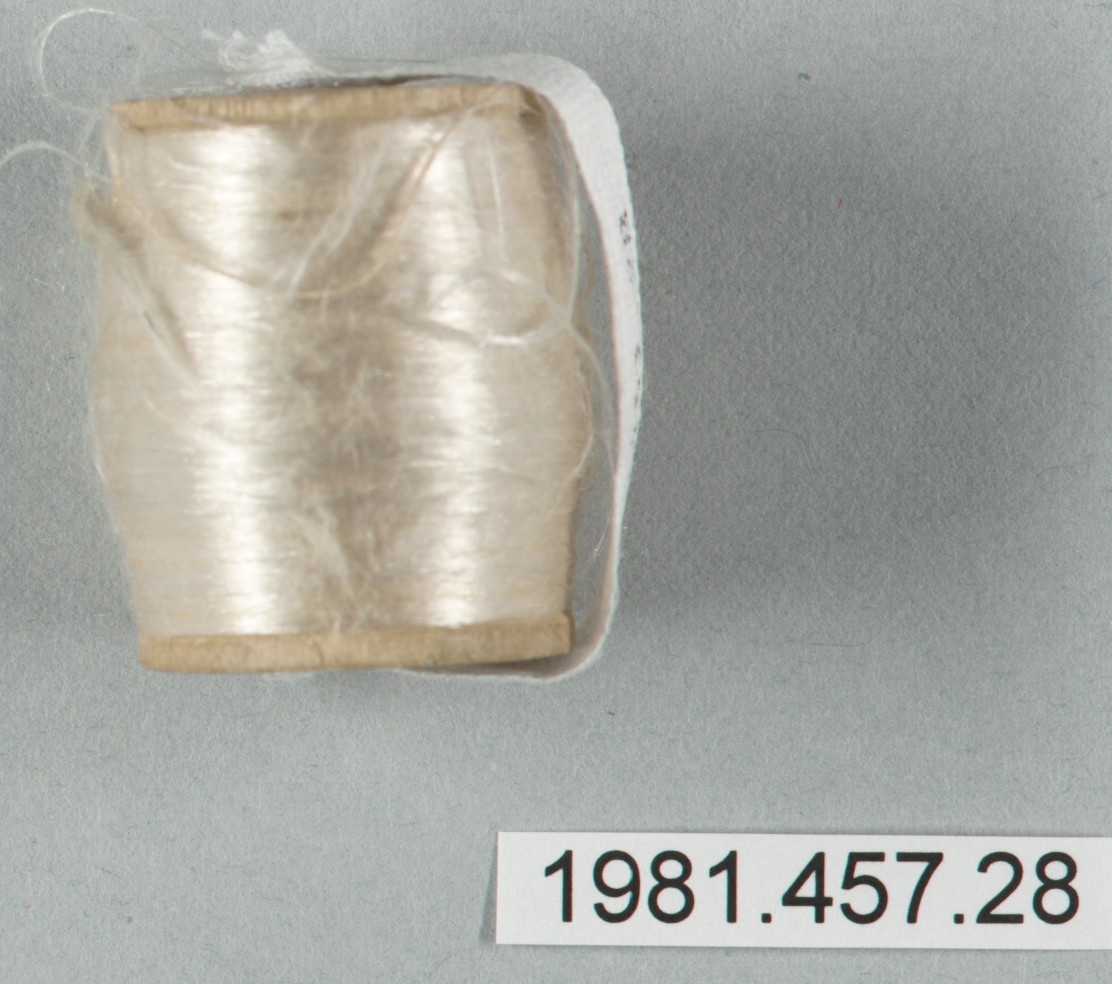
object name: spool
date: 1840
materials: silk, wood